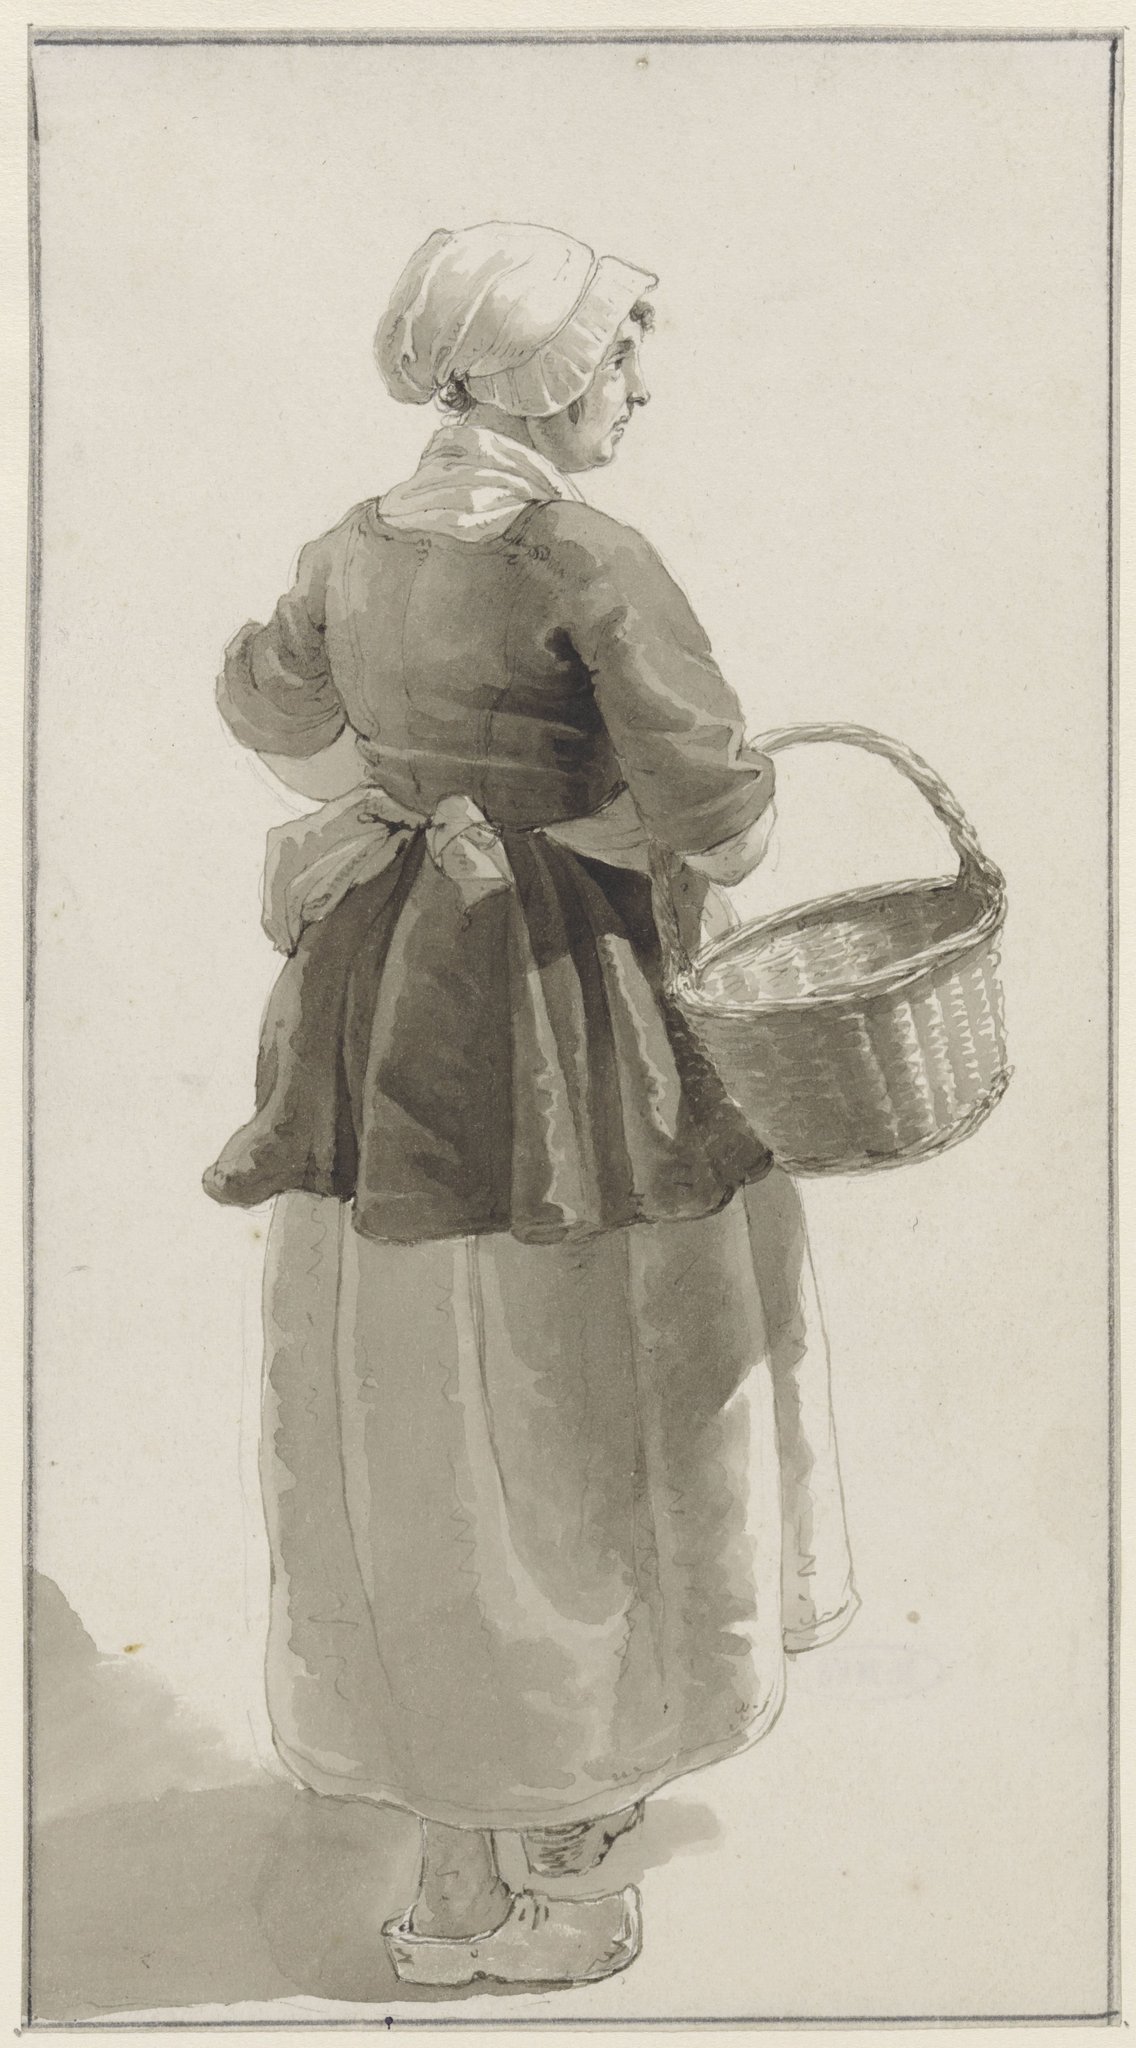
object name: drawing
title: Vrouw op klompen met mand, driekwart van achteren gezien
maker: johannes christiaan schotel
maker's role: draughtsman, painter, print maker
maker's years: 1787-1838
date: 1797-1838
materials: ink, paper, pencil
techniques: brush, pen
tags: standing figure, wooden shoes, clogs, container made of plant material other than wood: basket